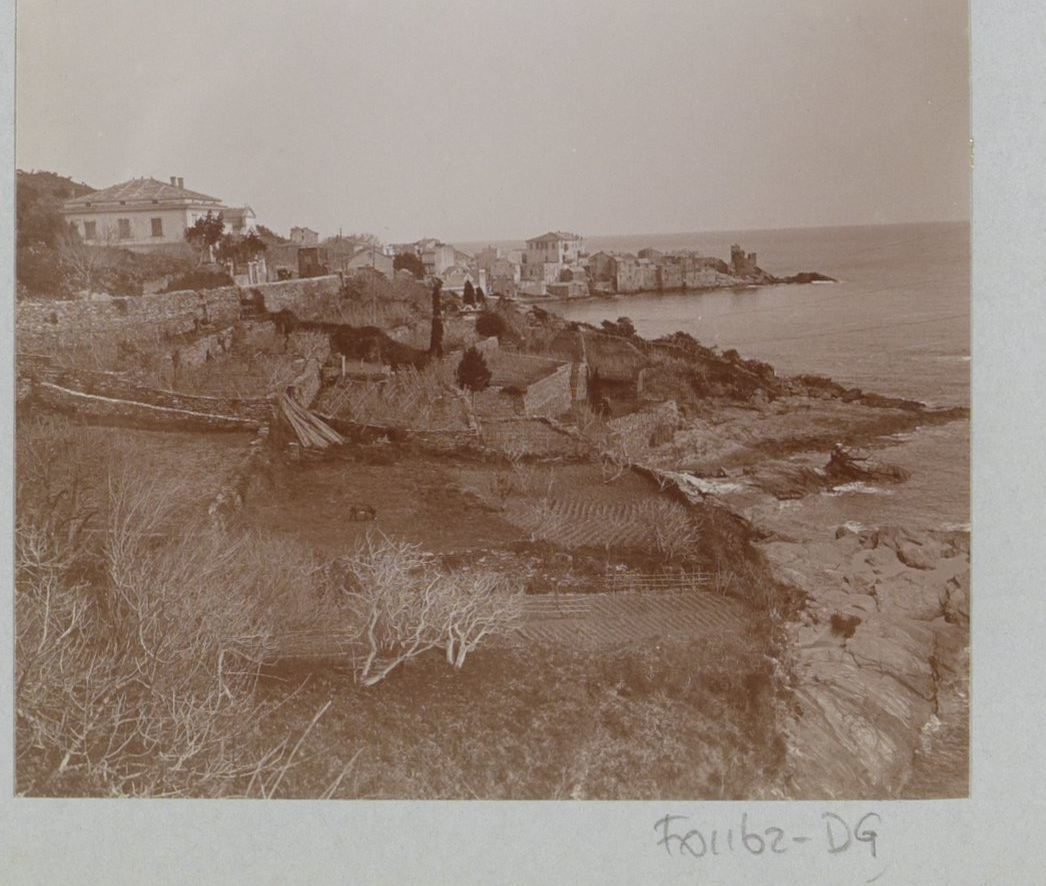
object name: photograph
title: Gezicht op Erbalunga op Corsica met op de voorgrond akkers en rotsen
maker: Anonymous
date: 1905-1910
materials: paper, photographic support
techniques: gelatin silver print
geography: erbalunga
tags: prospect of village, silhouette of village, landscape with tower or castle, coast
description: Onderdeel van Fotoalbum van een Franse amateurfotograaf met bezienswaardigheden in Frankrijk, Zwitserland en Italië.